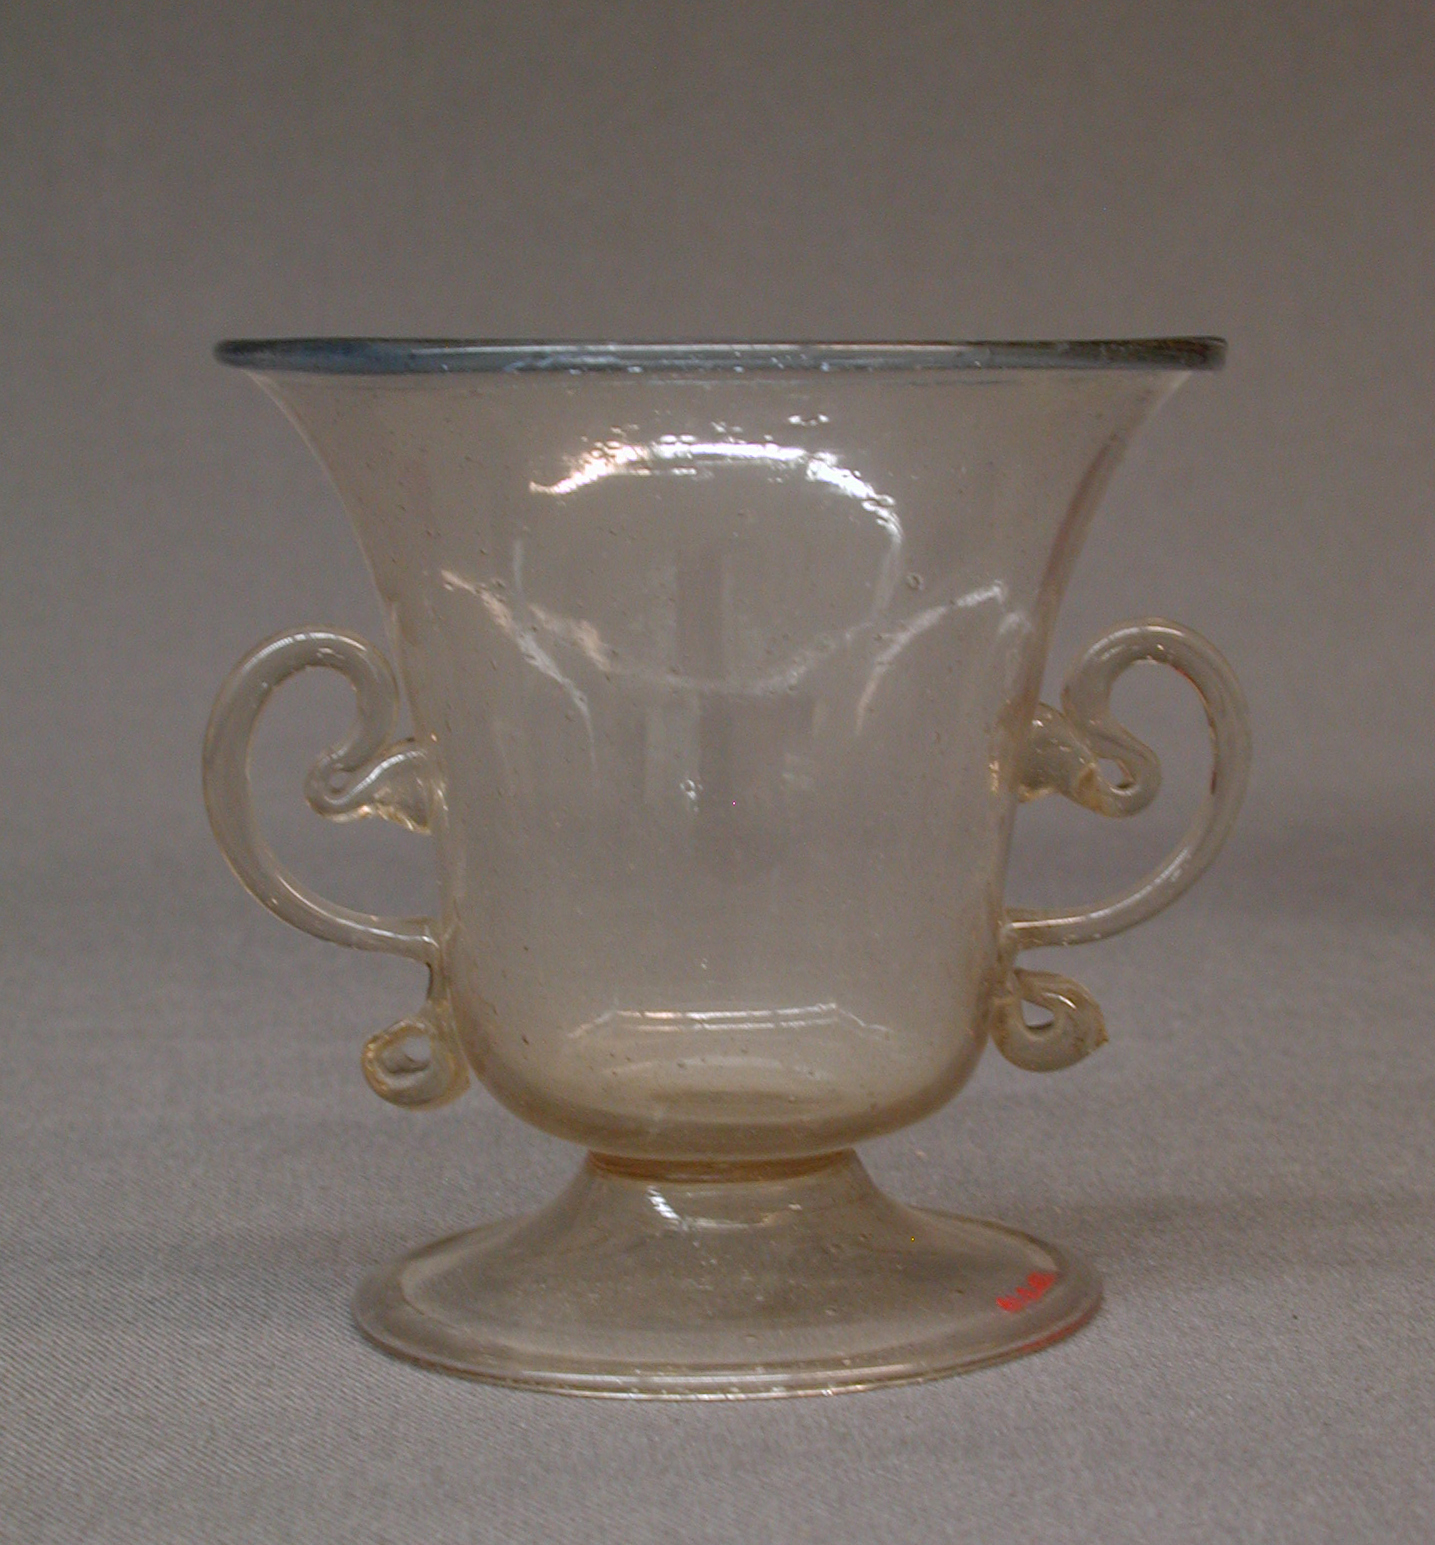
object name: cup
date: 1601-1700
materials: glass